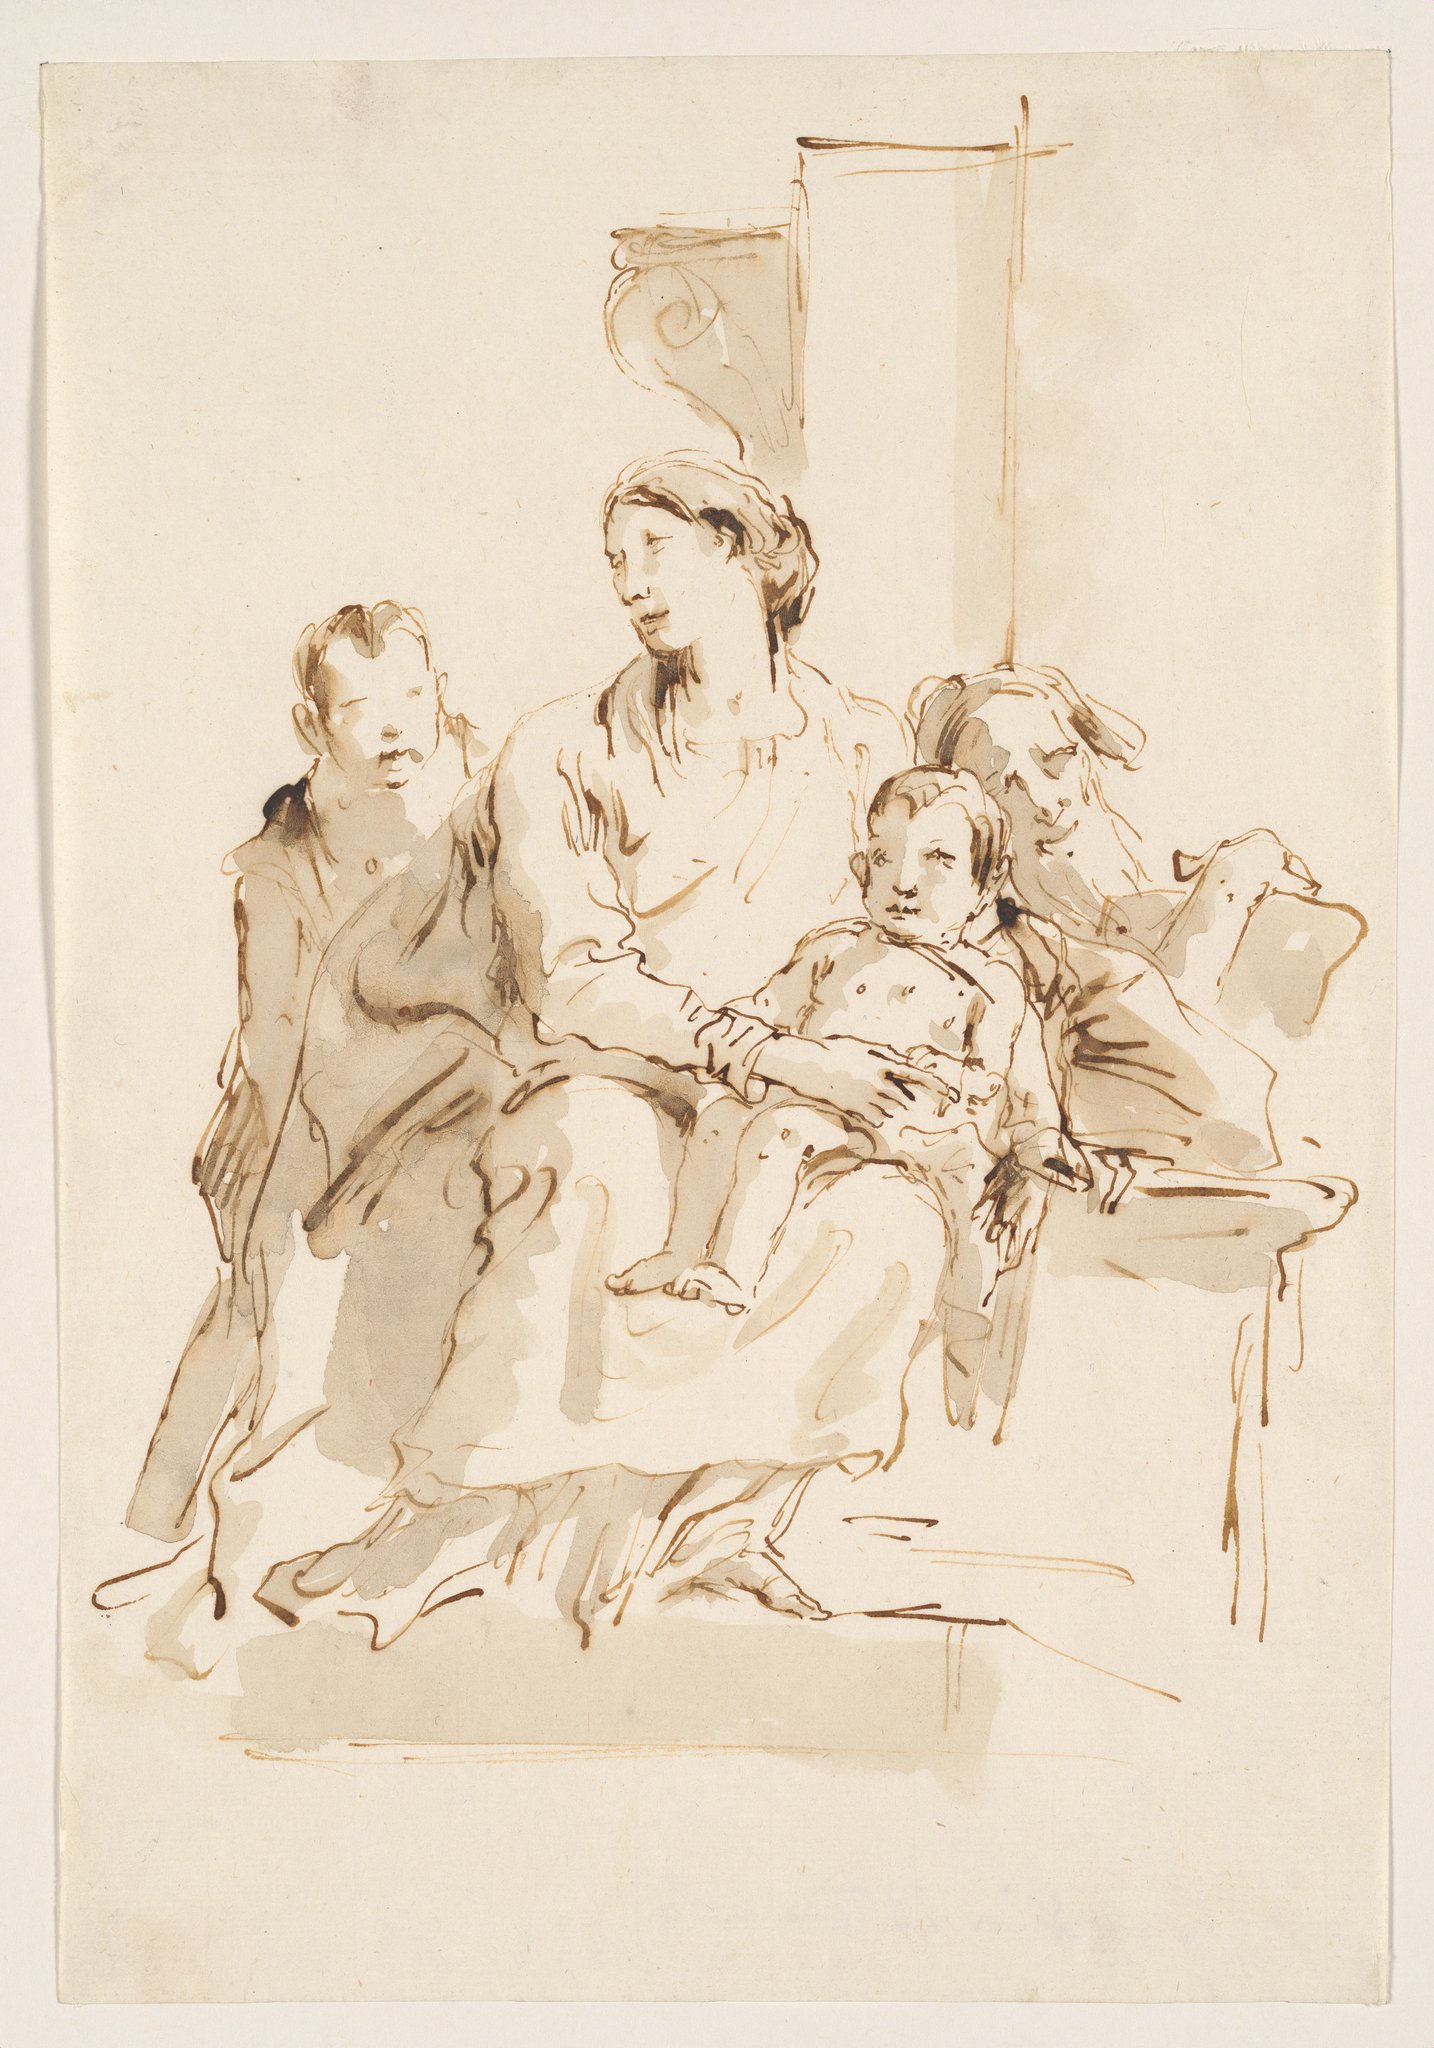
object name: drawing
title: The Holy Family with Saint John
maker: giovanni battista tiepolo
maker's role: artist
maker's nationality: italian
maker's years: 1696-1770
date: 1754-1762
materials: ink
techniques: pen, wash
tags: holy family,saint john the baptist